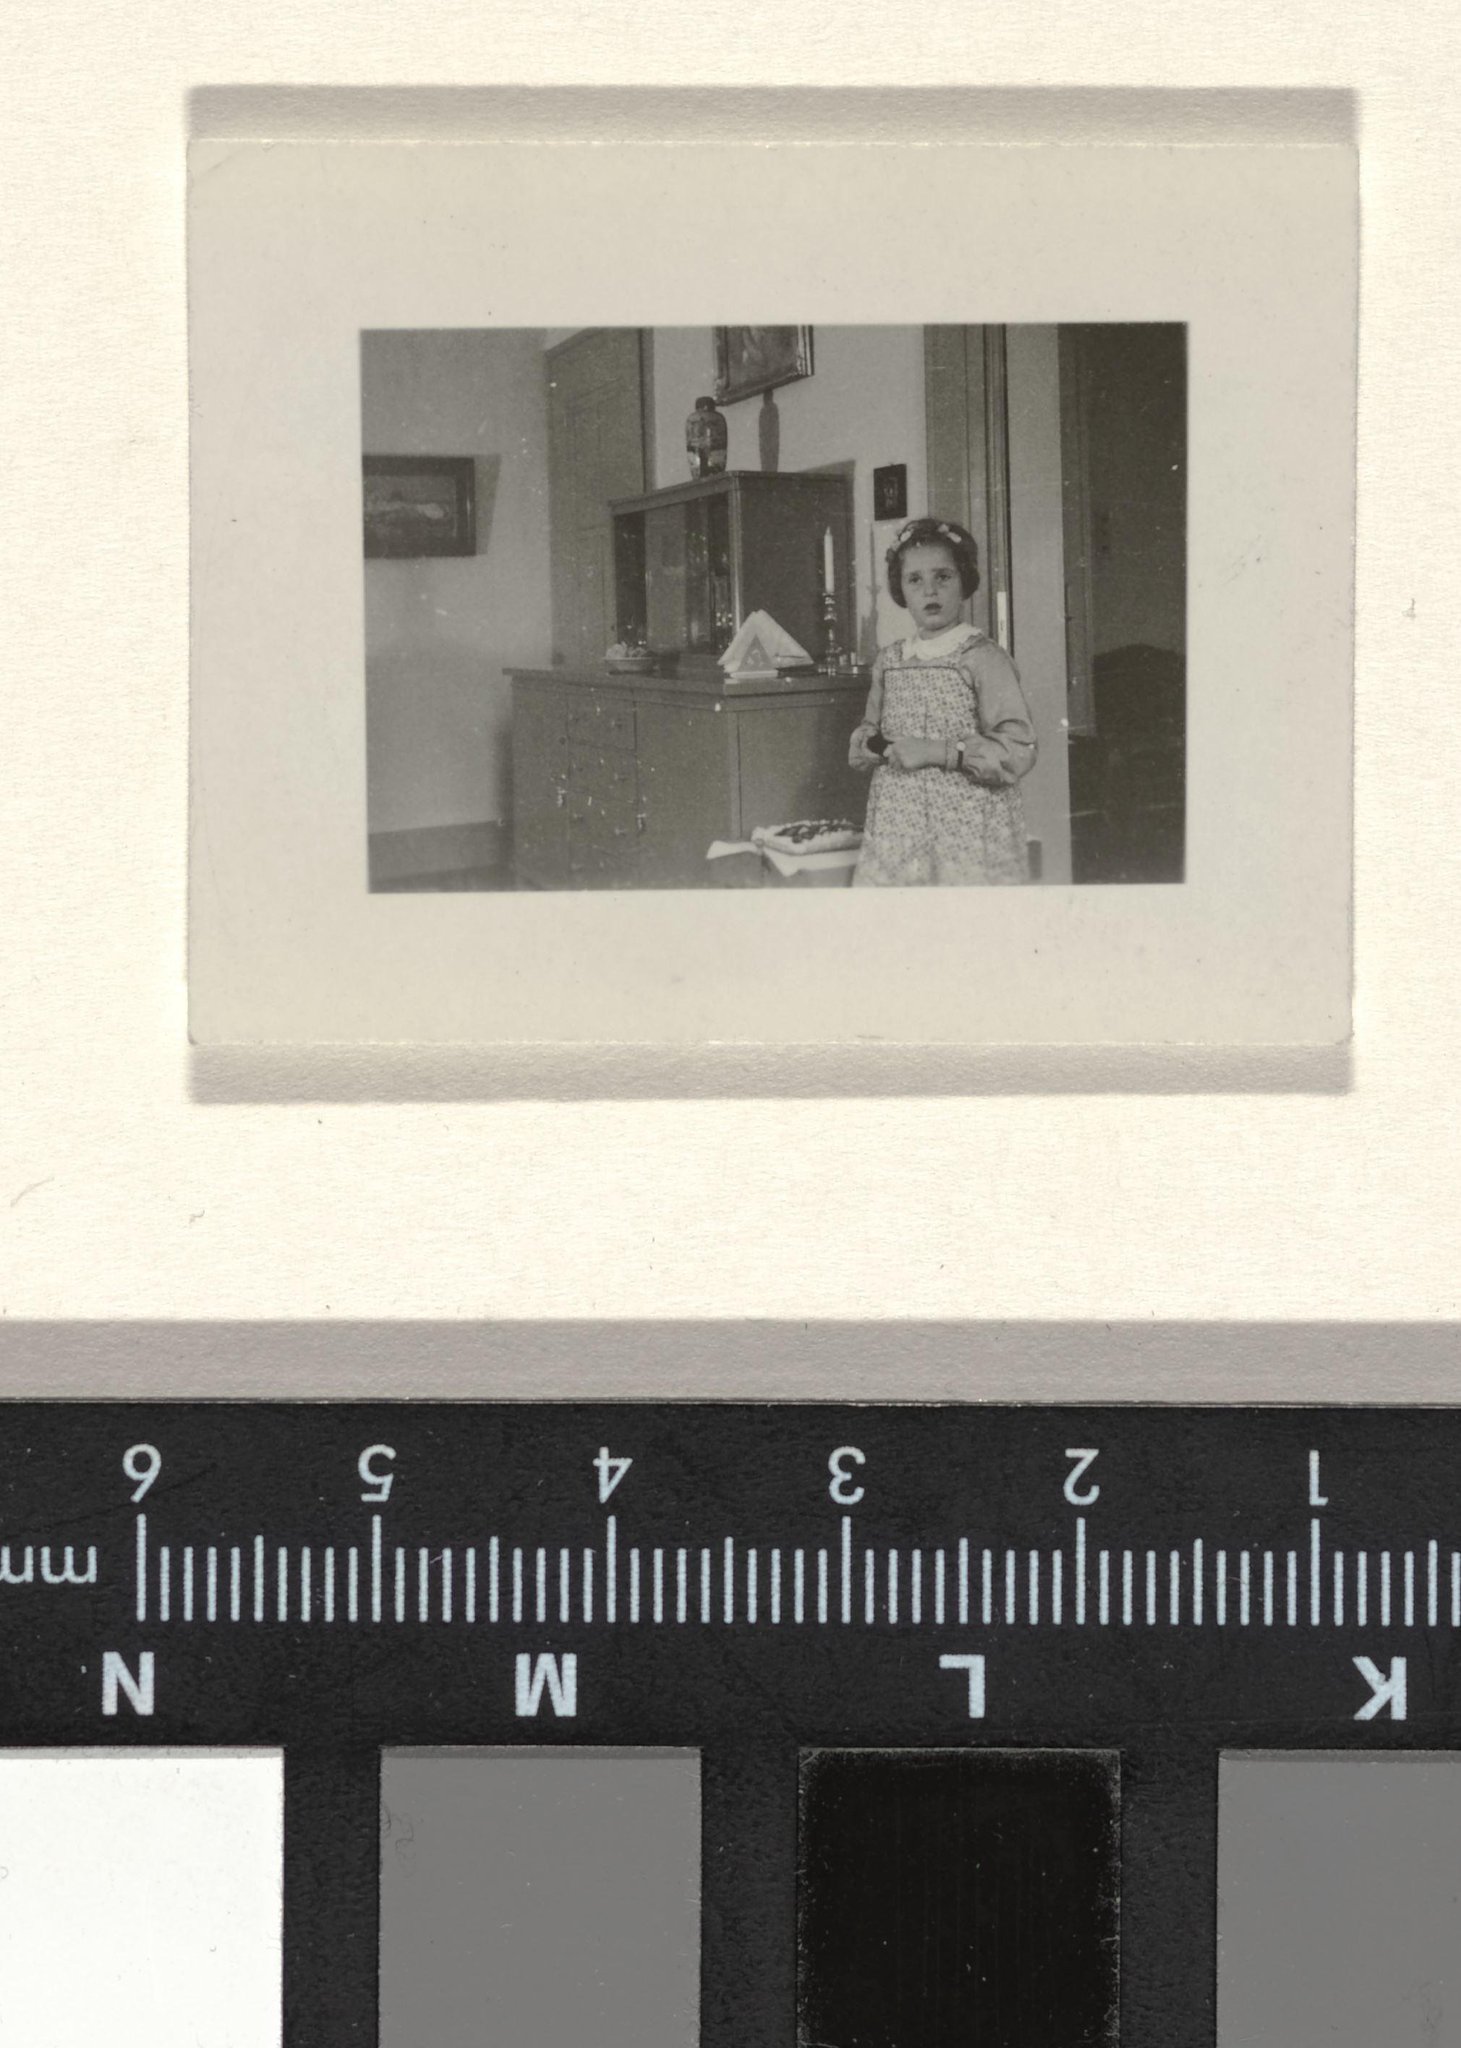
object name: photograph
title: Isabel Wachenheimer met gestreepte jurk en krans in het haar voor een kast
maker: Anonymous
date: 1933-1936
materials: photographic support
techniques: gelatin silver print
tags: leiden, isabel wachenheimer-elon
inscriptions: inscription: ‘Kännst Du auch das kleine Schätlein an seinen 6. 2 feb. tag 2’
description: Isabel Wachenheimer met gestreepte jurk en krans in het haar voor een kast.